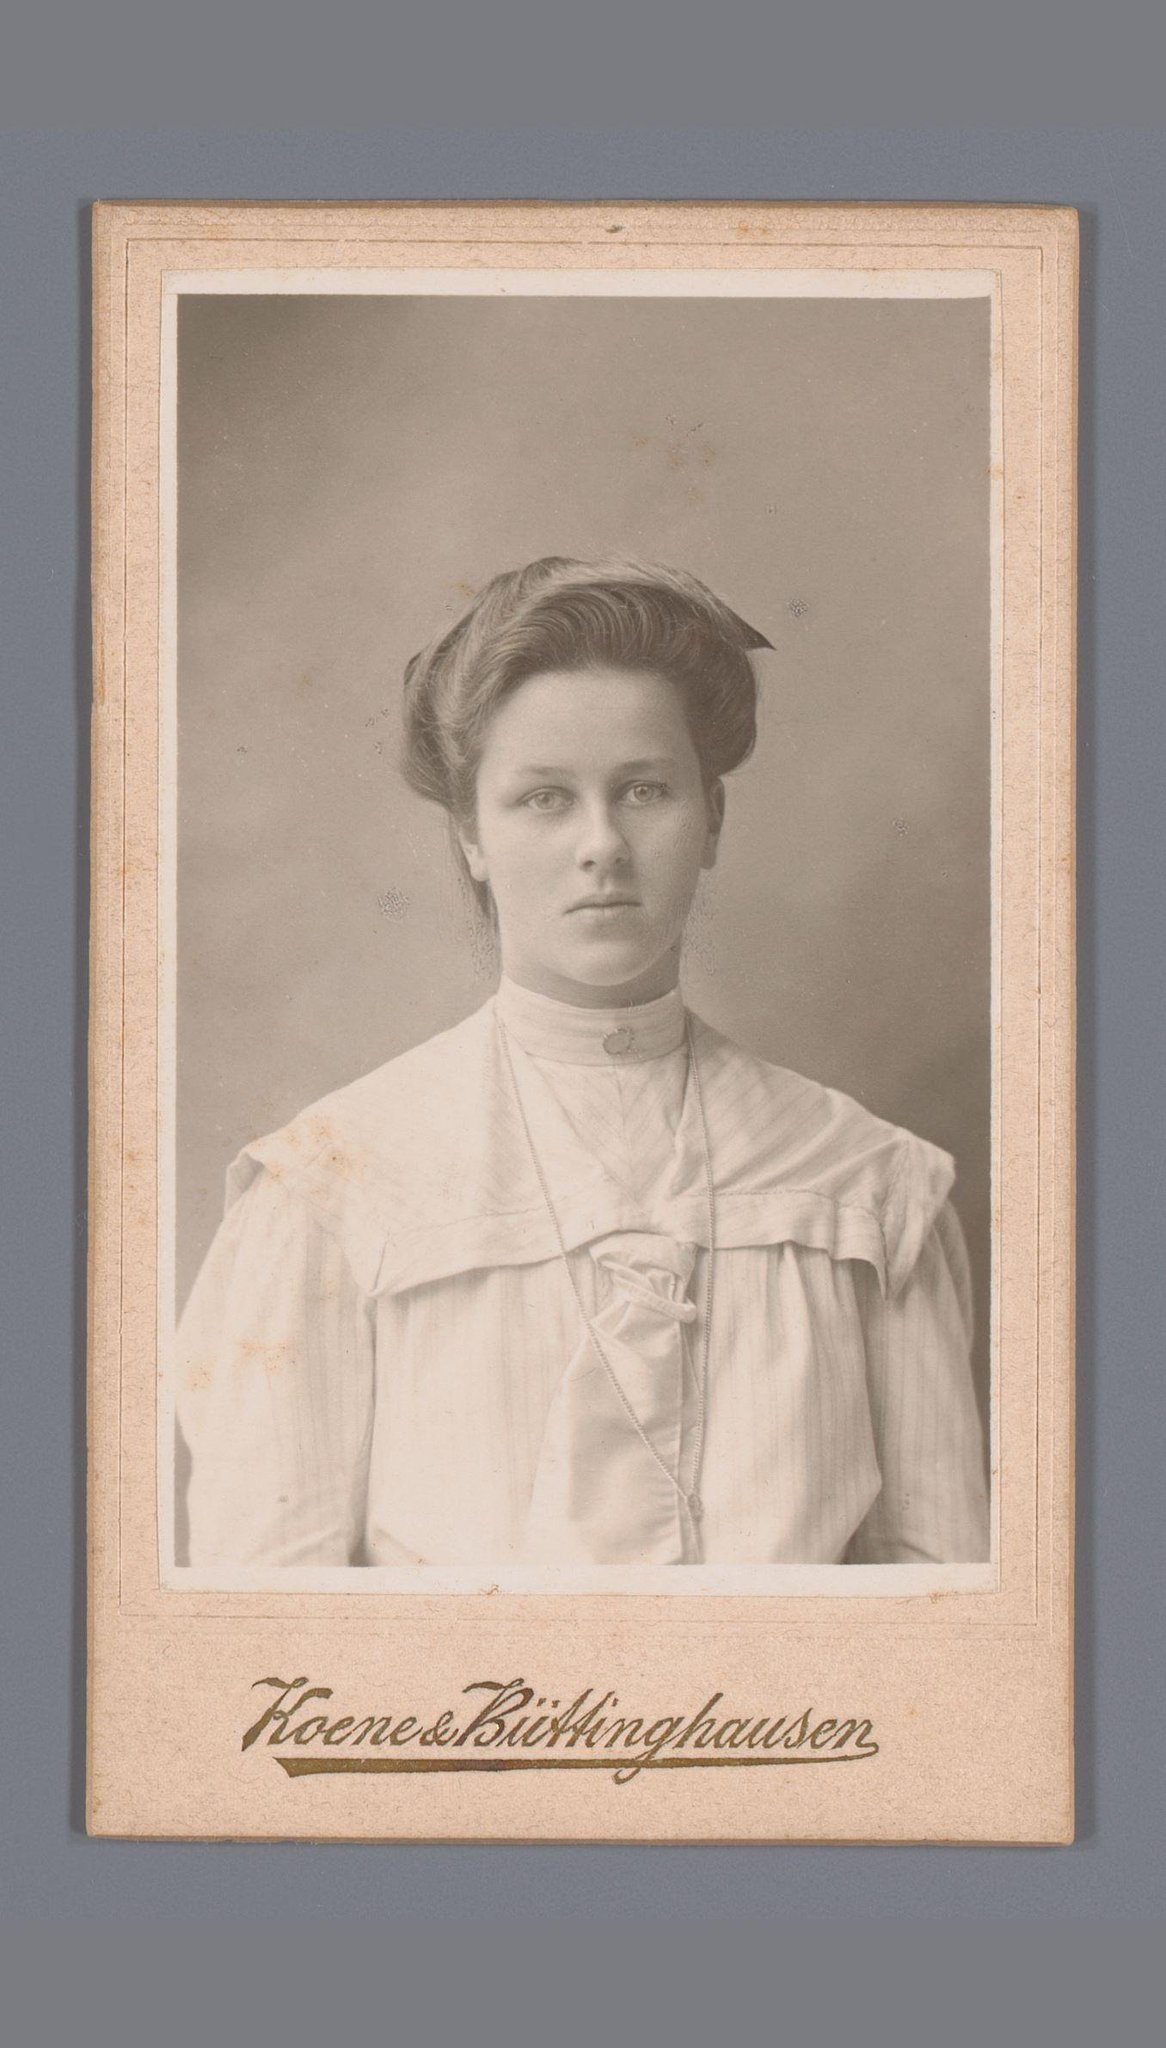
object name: photograph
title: Portret van Johanna Geertruida Jonker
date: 1907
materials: cardboard, photographic support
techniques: gelatin silver print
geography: amsterdam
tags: historical persons, amsterdam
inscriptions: annotation: ‘Hansje Jonker 1907’, workshop stamp: ‘Koene&Büttinghausen/ Amsterdam Heerengracht 150, Telephoonnummer 1402/ Batavia’